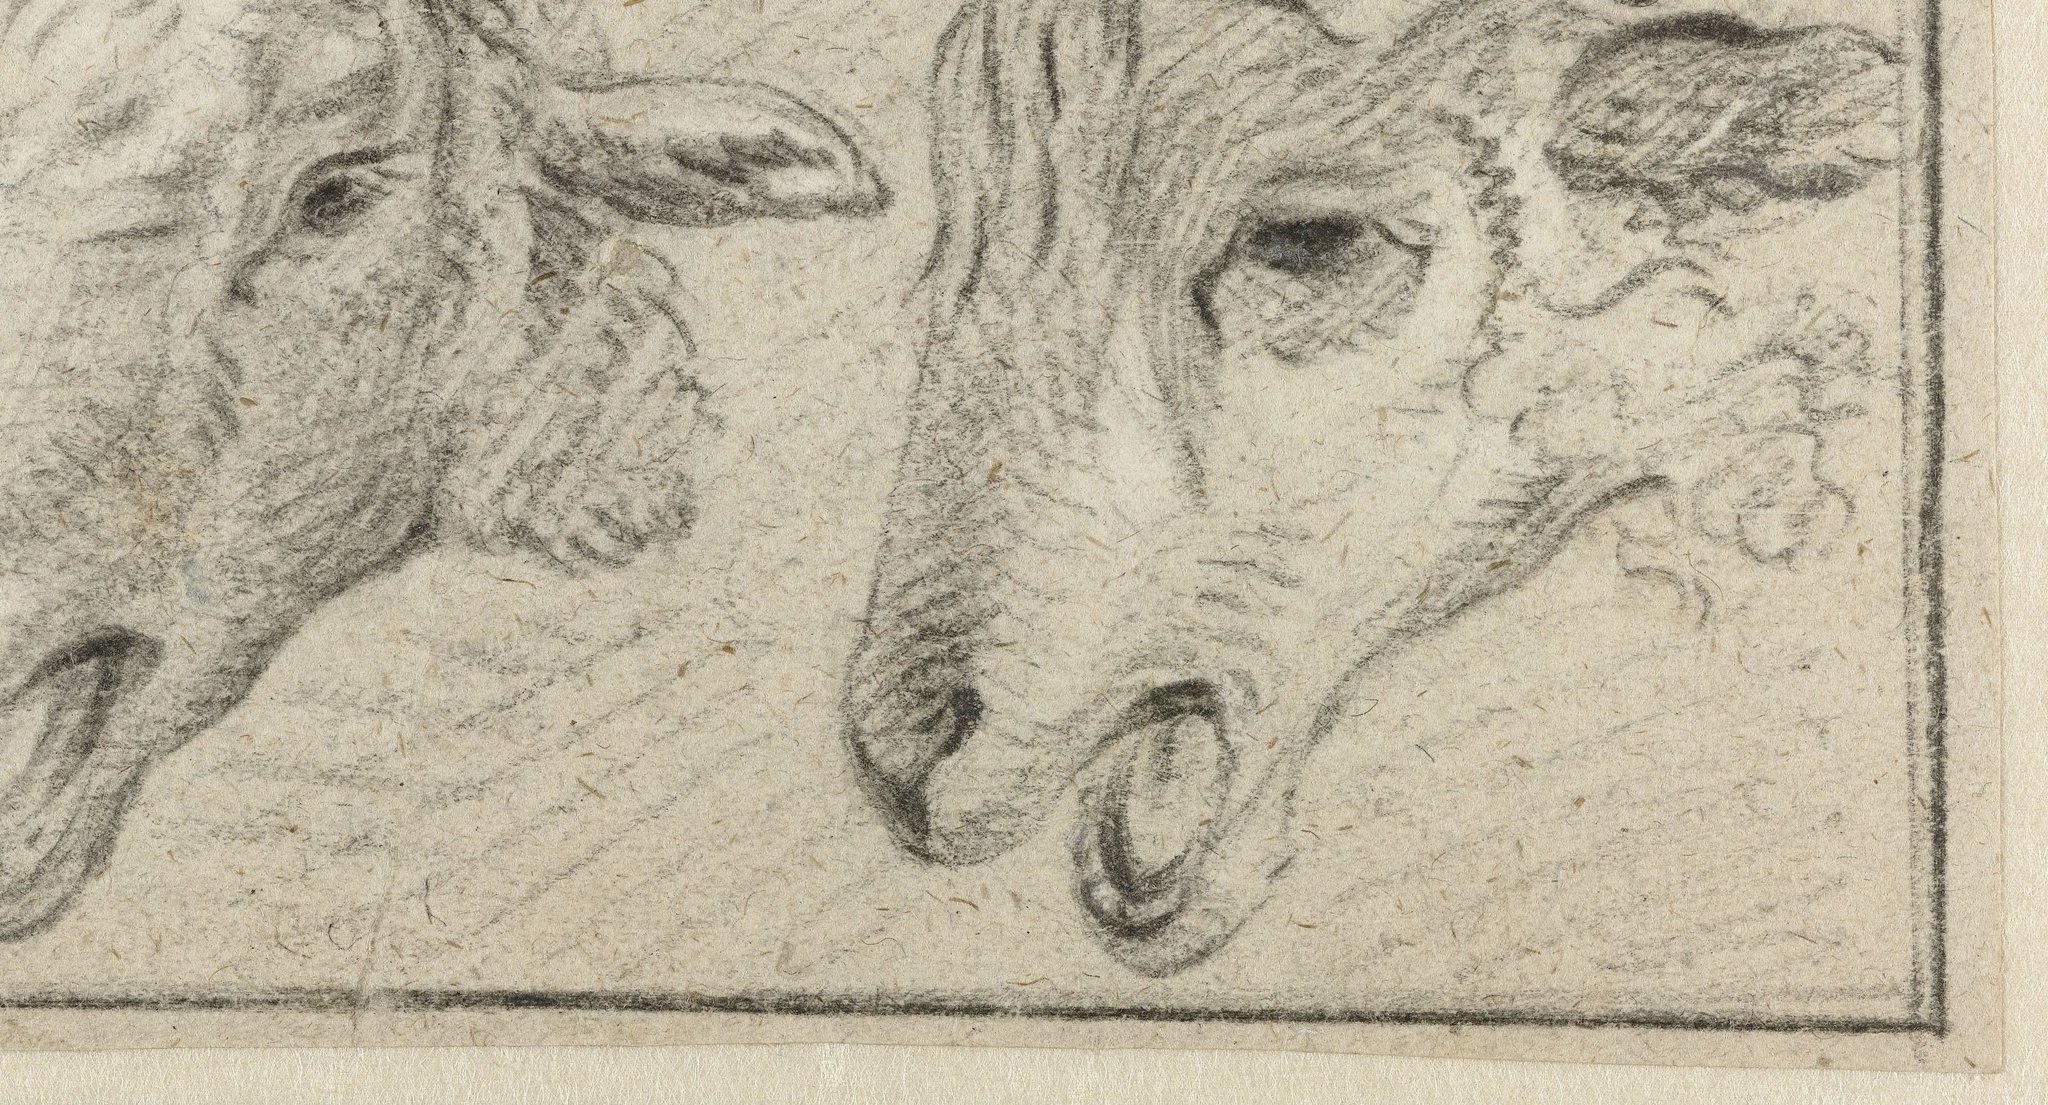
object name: drawing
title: Twee schapenkoppen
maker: adriaen van de velde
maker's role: draughtsman, painter, print maker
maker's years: 1636-1672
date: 1646-1672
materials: chalk, paper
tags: sheep (+ head of an animal)